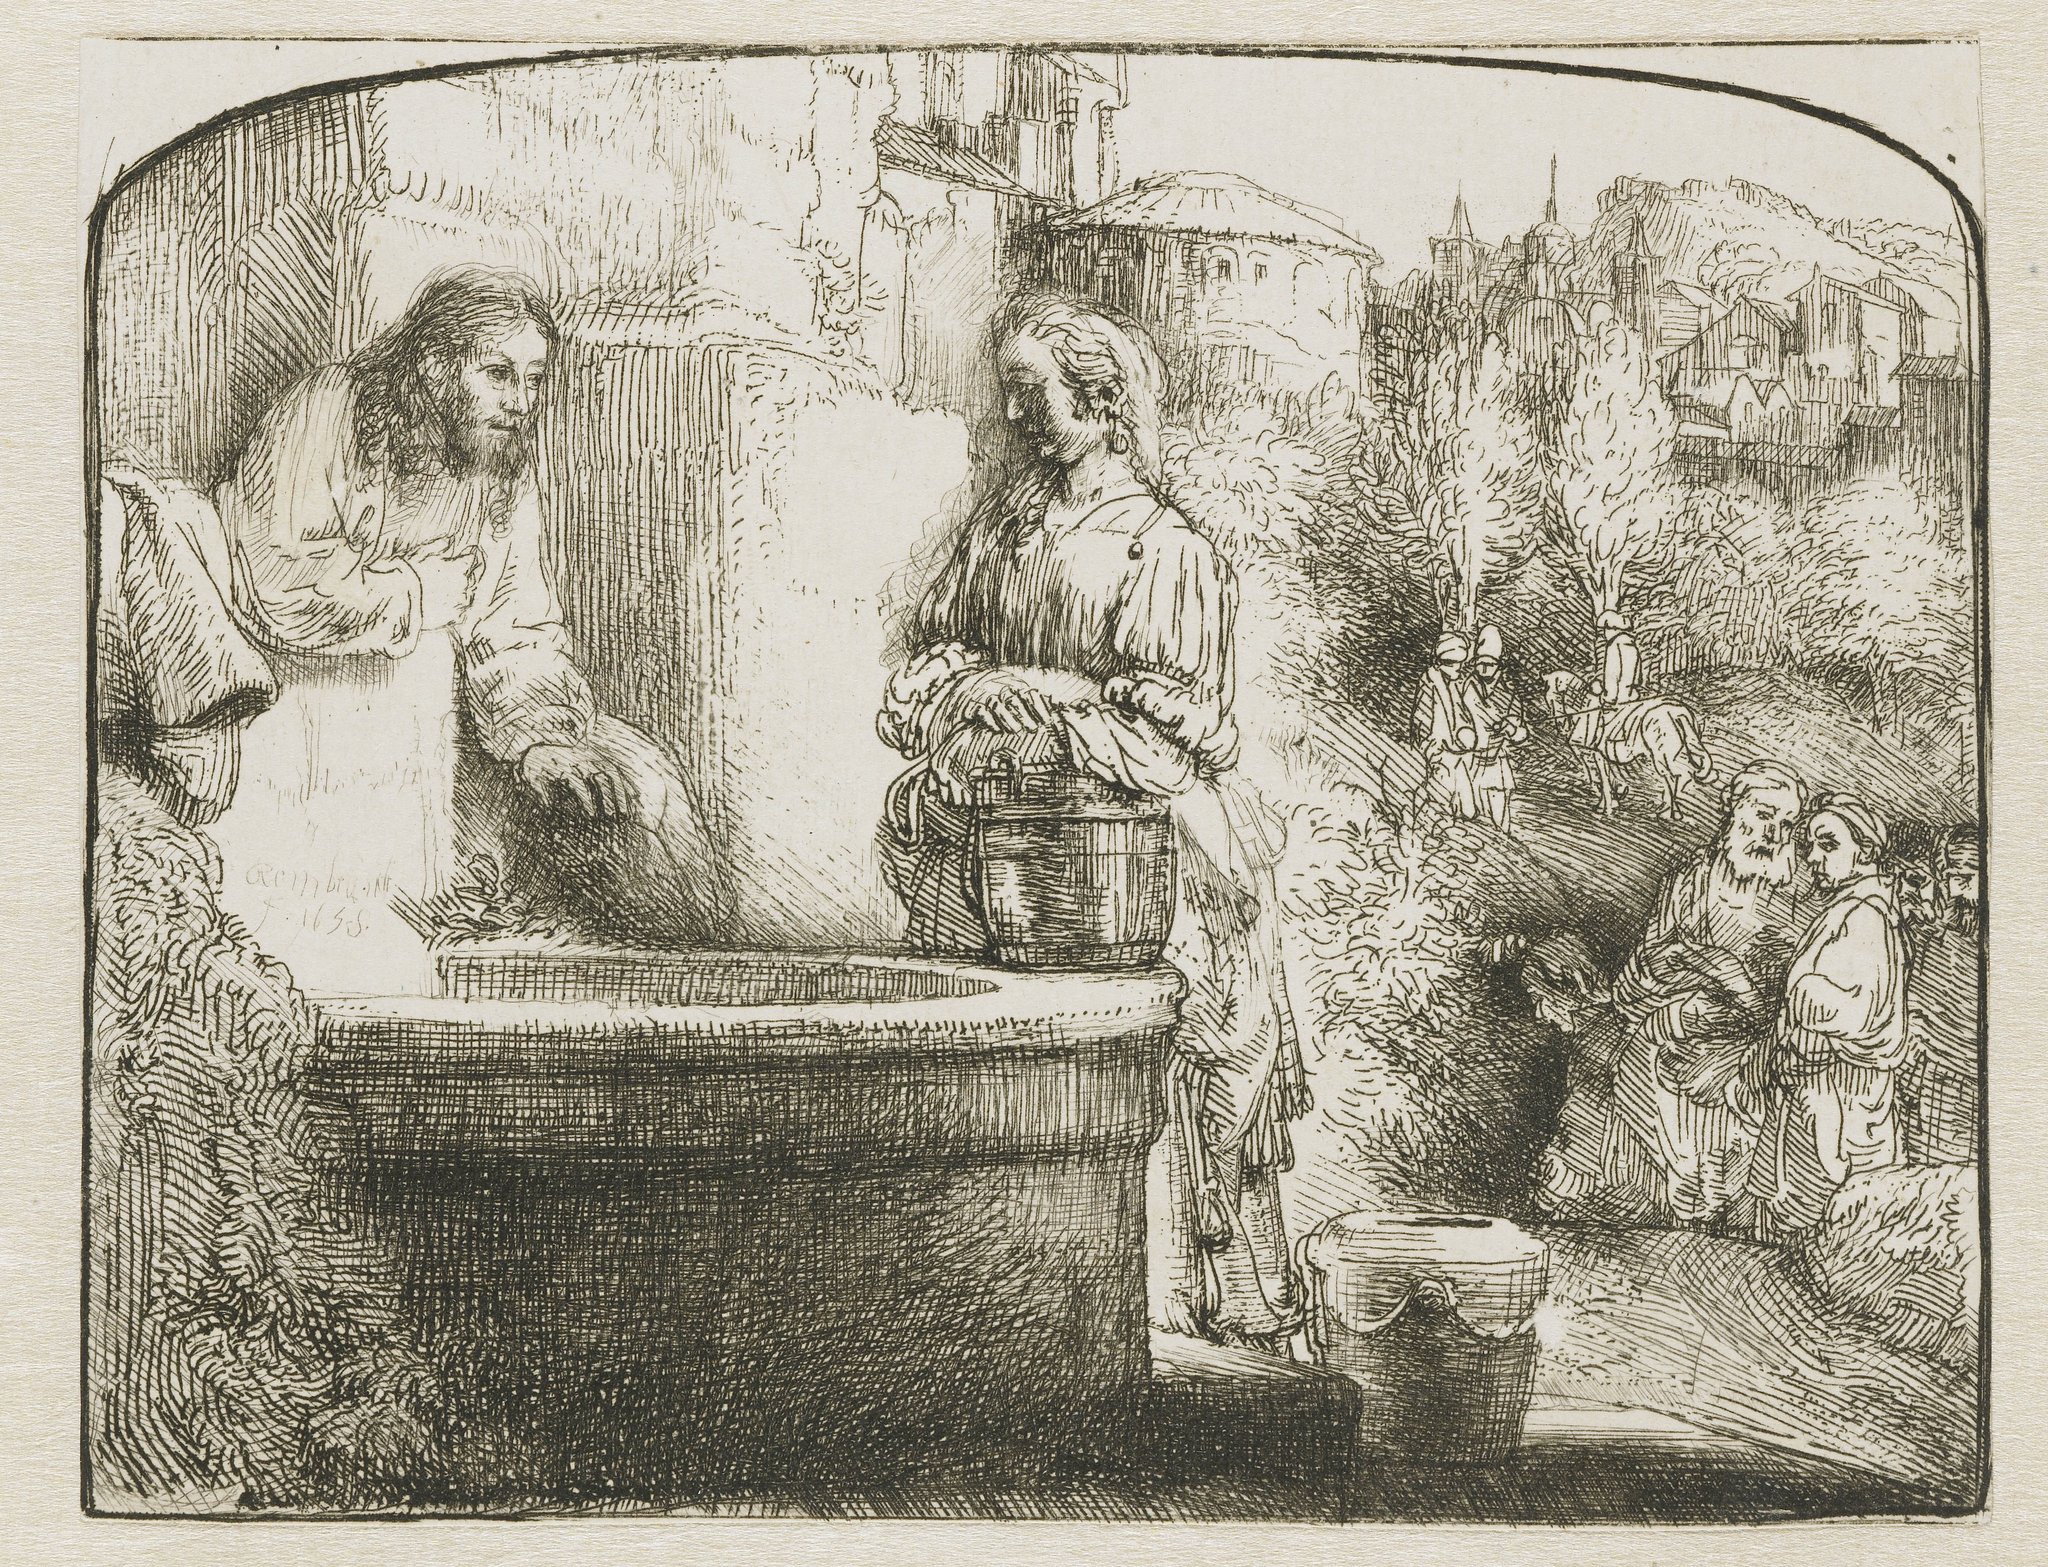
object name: print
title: Christ and the woman of Samaria: an arched print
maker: rembrandt van rijn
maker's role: draughtsman, painter, print maker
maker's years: 1606-1669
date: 1657-1658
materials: paper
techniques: drypoint, etching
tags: the woman of samaria (john 4:4-42)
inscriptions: signature and date: ‘Rembrandt f. 1658’, signature and date: ‘Rembrandt f. 1657’, mark: Lugt 1073 a, mark: Lugt 2228 a, mark: ‘CdE Geneve (in een cirkel), doublet’